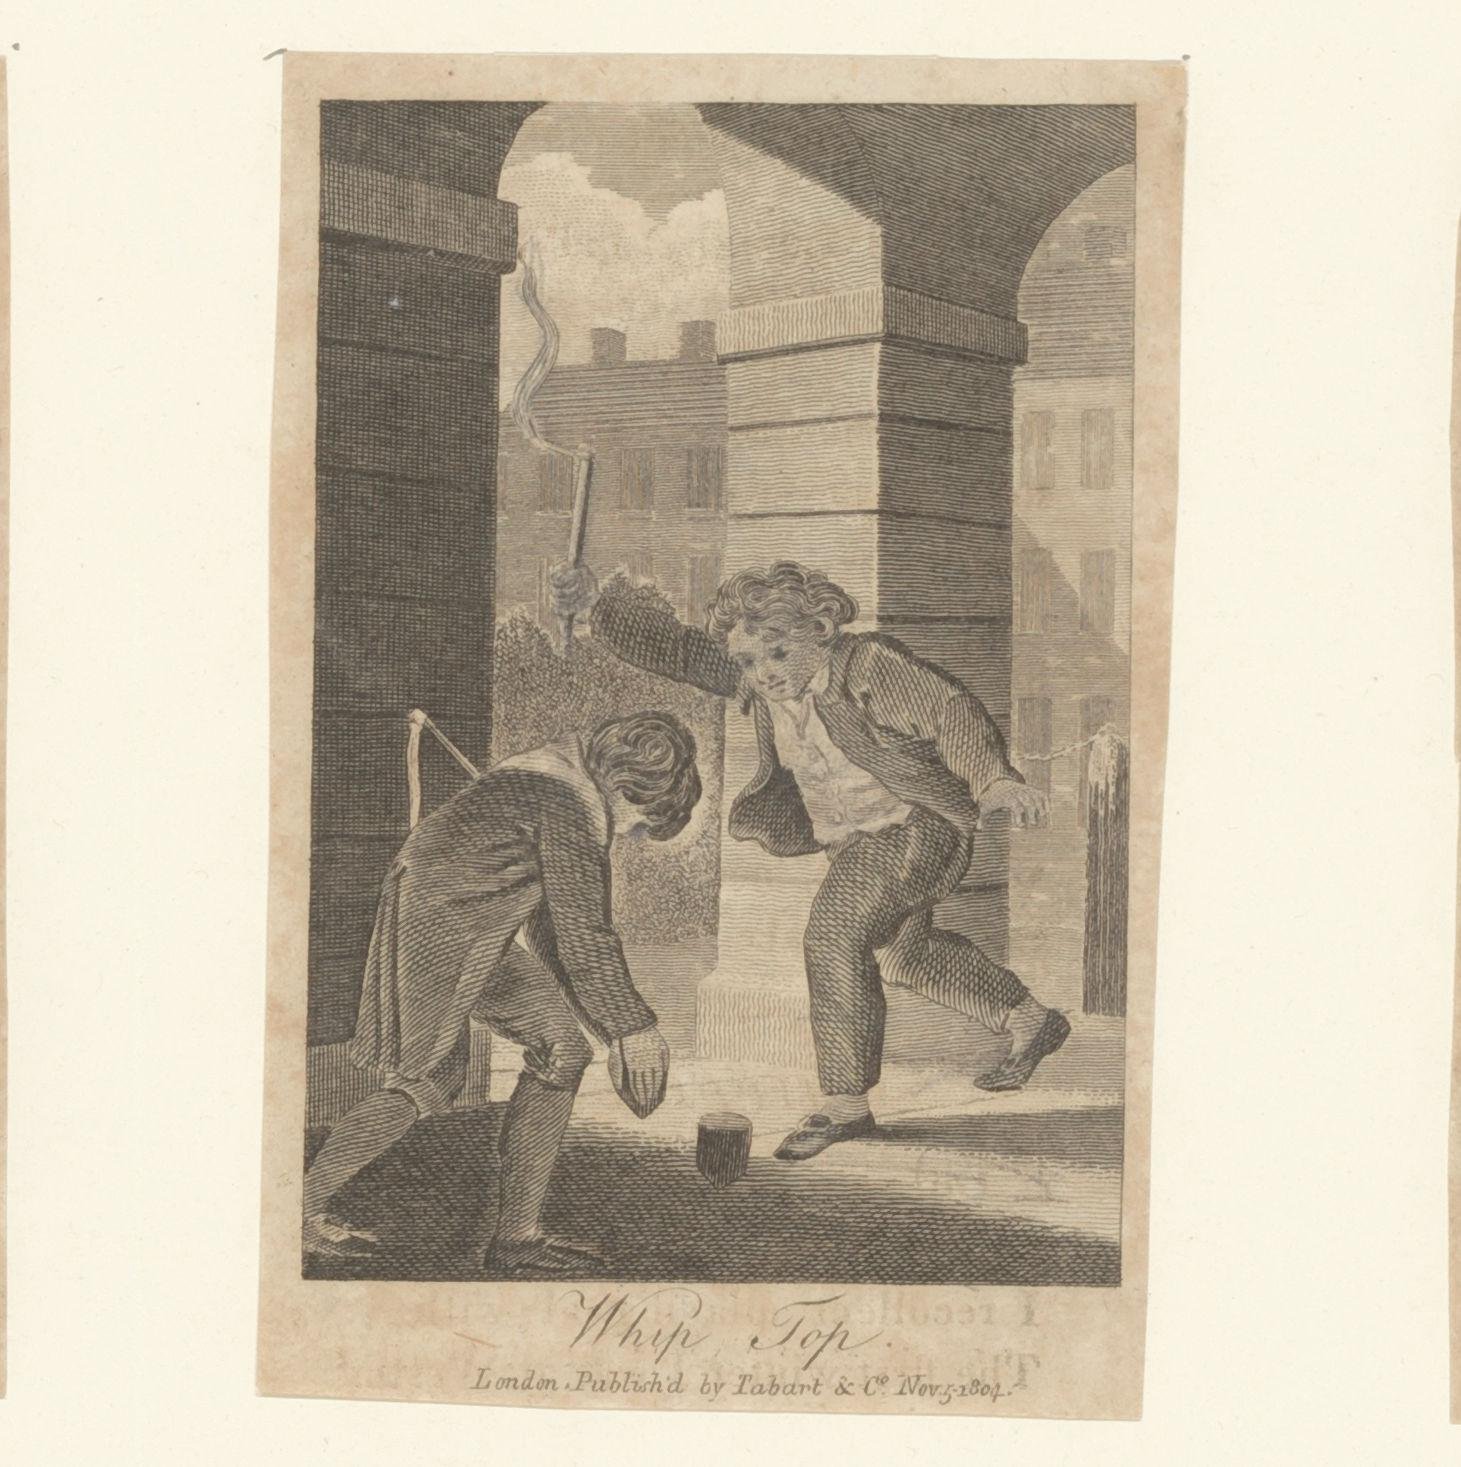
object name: print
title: Twee kinderen spelen met een drijftol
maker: Anonymous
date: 1812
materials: paper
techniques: engraving, etching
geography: london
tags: children's games and plays, whipping a top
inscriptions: collector's mark: Lugt 1641, stamp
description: Onderwerpsrubrieken binnen de Atlas Zeden en Gewoonten: Zeden en Gewoonten in Engeren Zin, Des menschen beging, midden en einde, Kinderleven – Kinderspel en Kinderprenten.